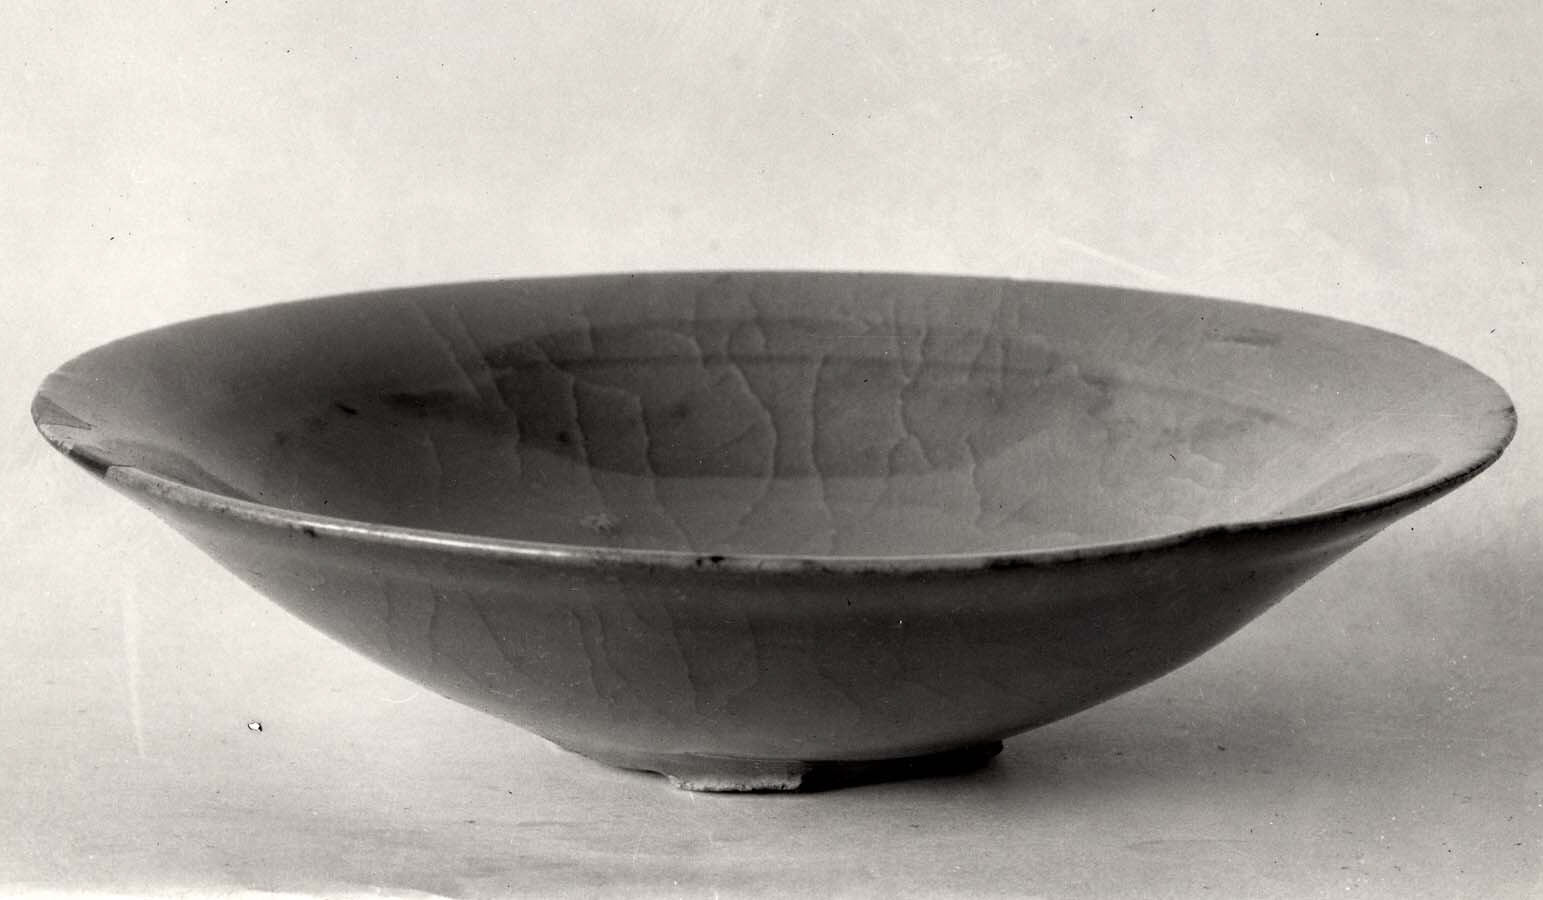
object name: saucer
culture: korean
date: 918-1392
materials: clay